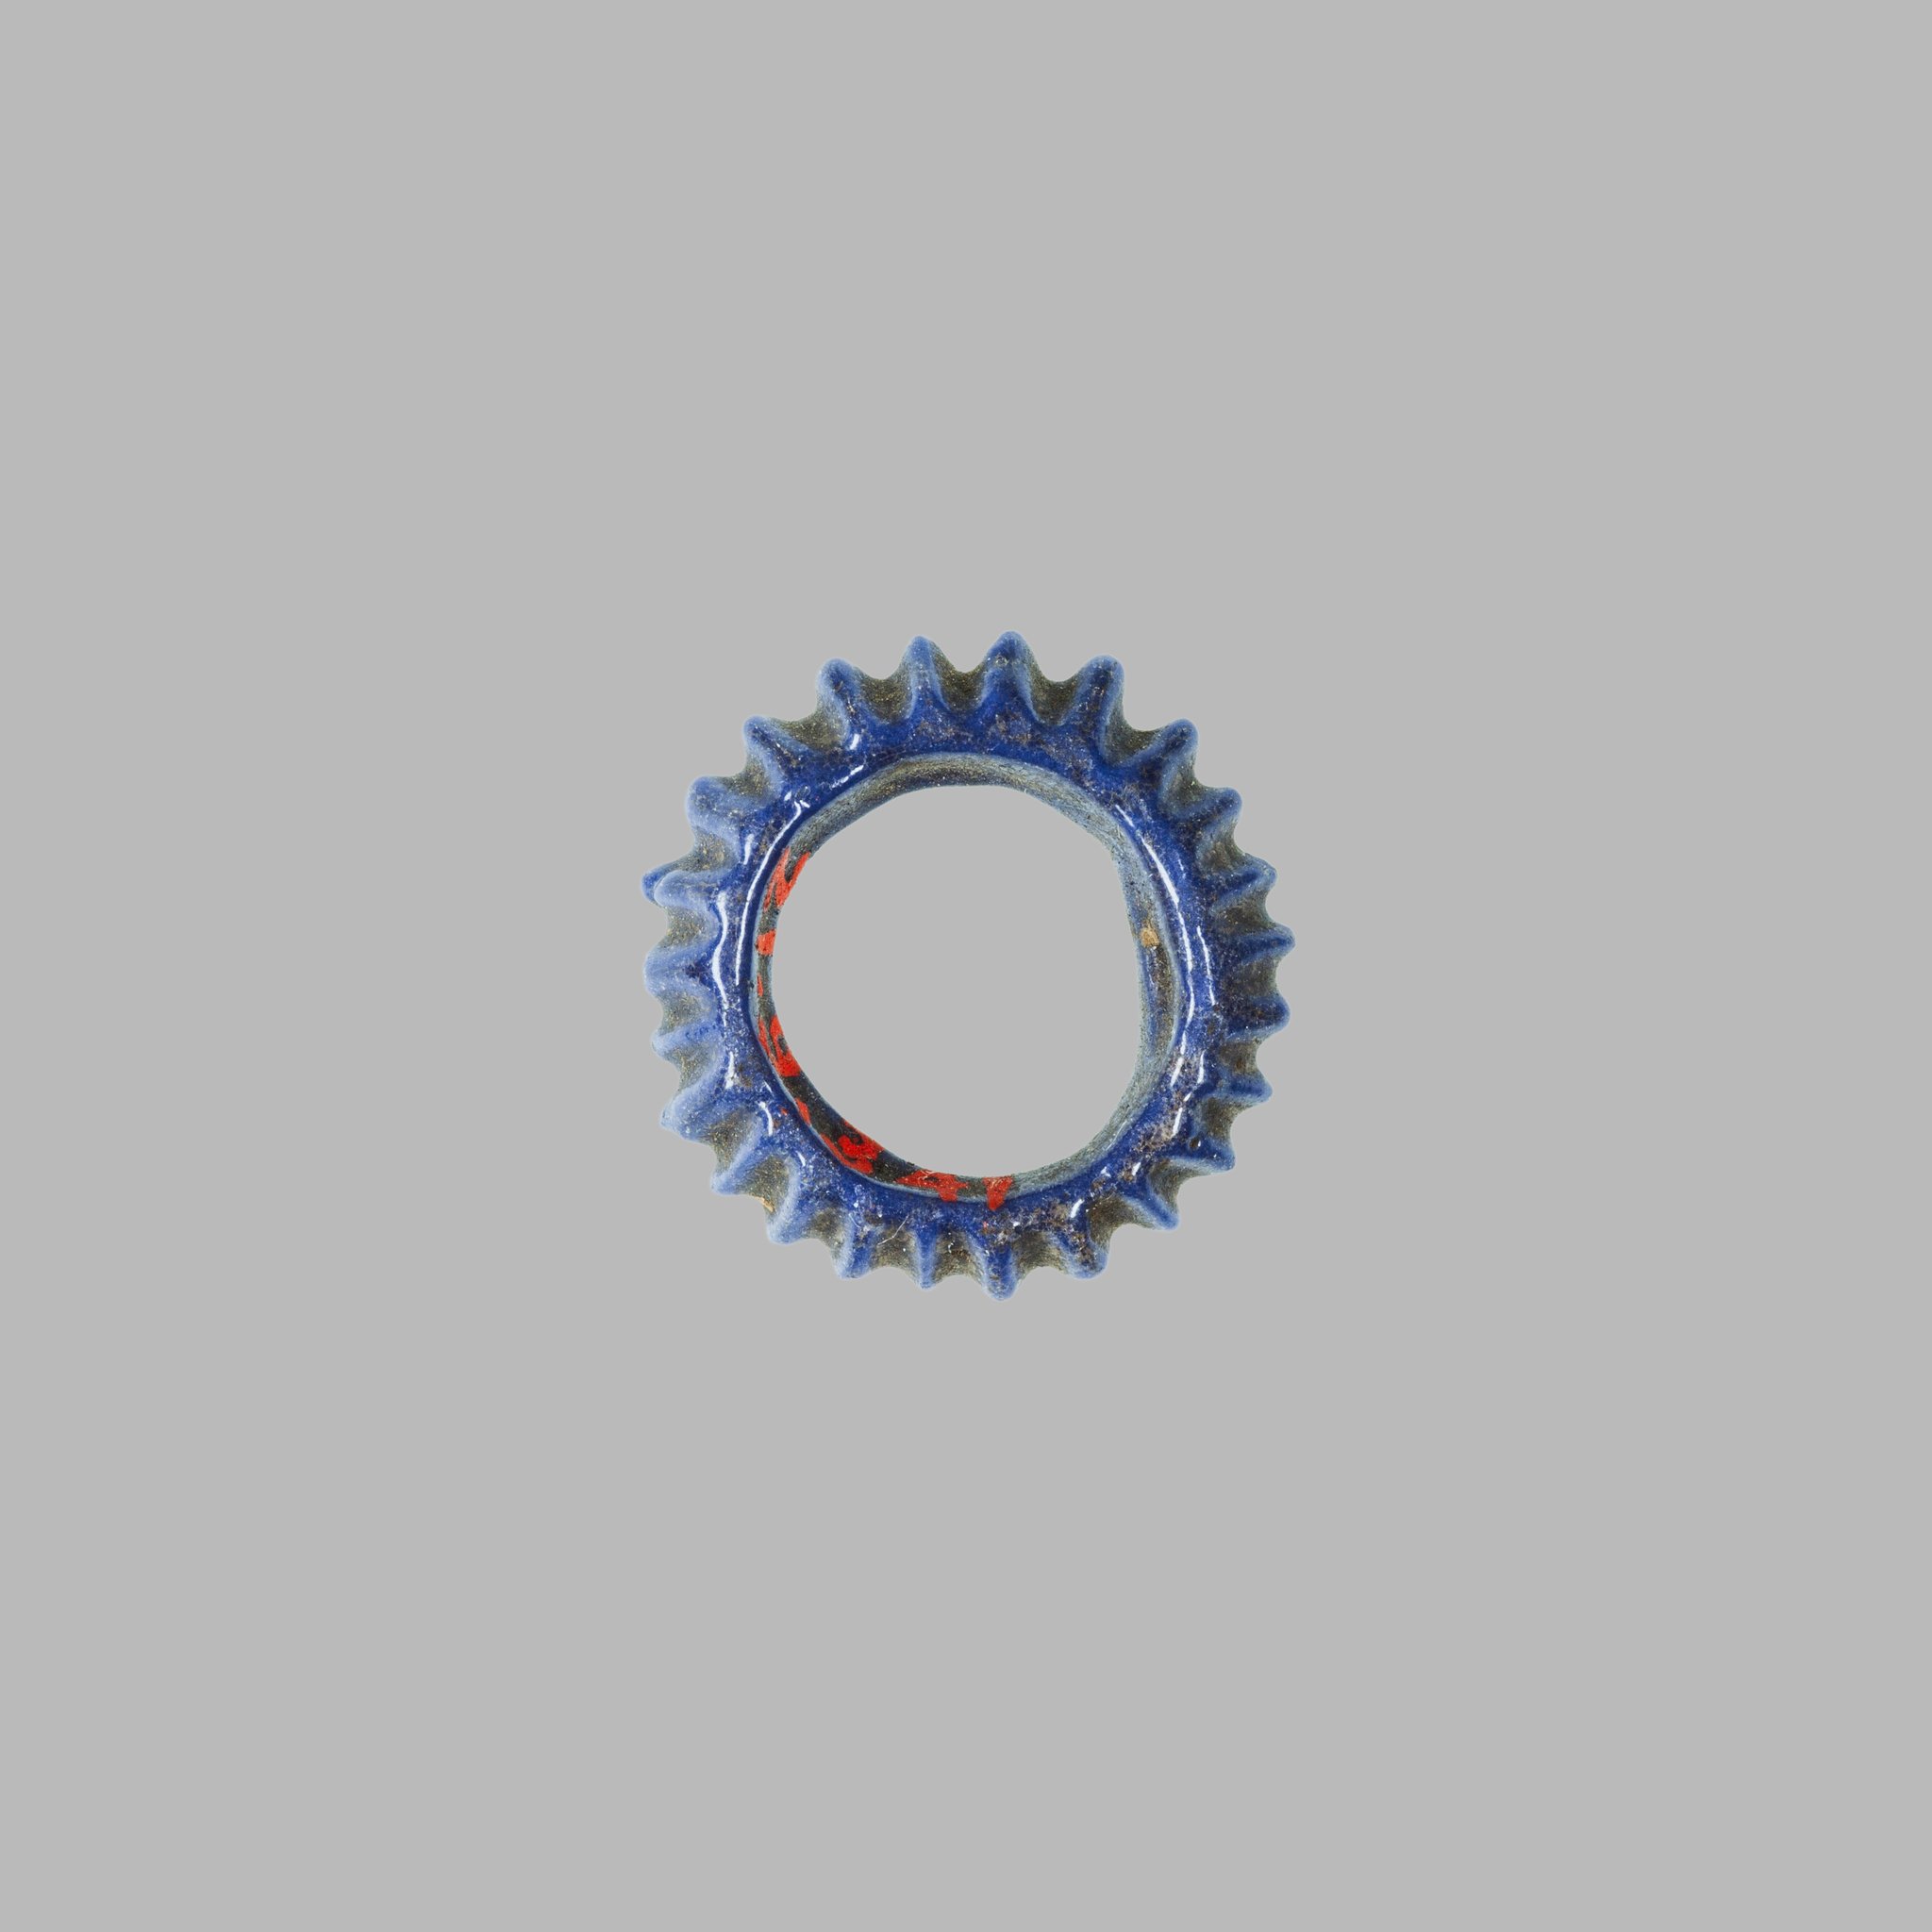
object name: pendant, rosette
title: Rosette Pendant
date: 1353-1336 BCE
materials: faience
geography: egypt